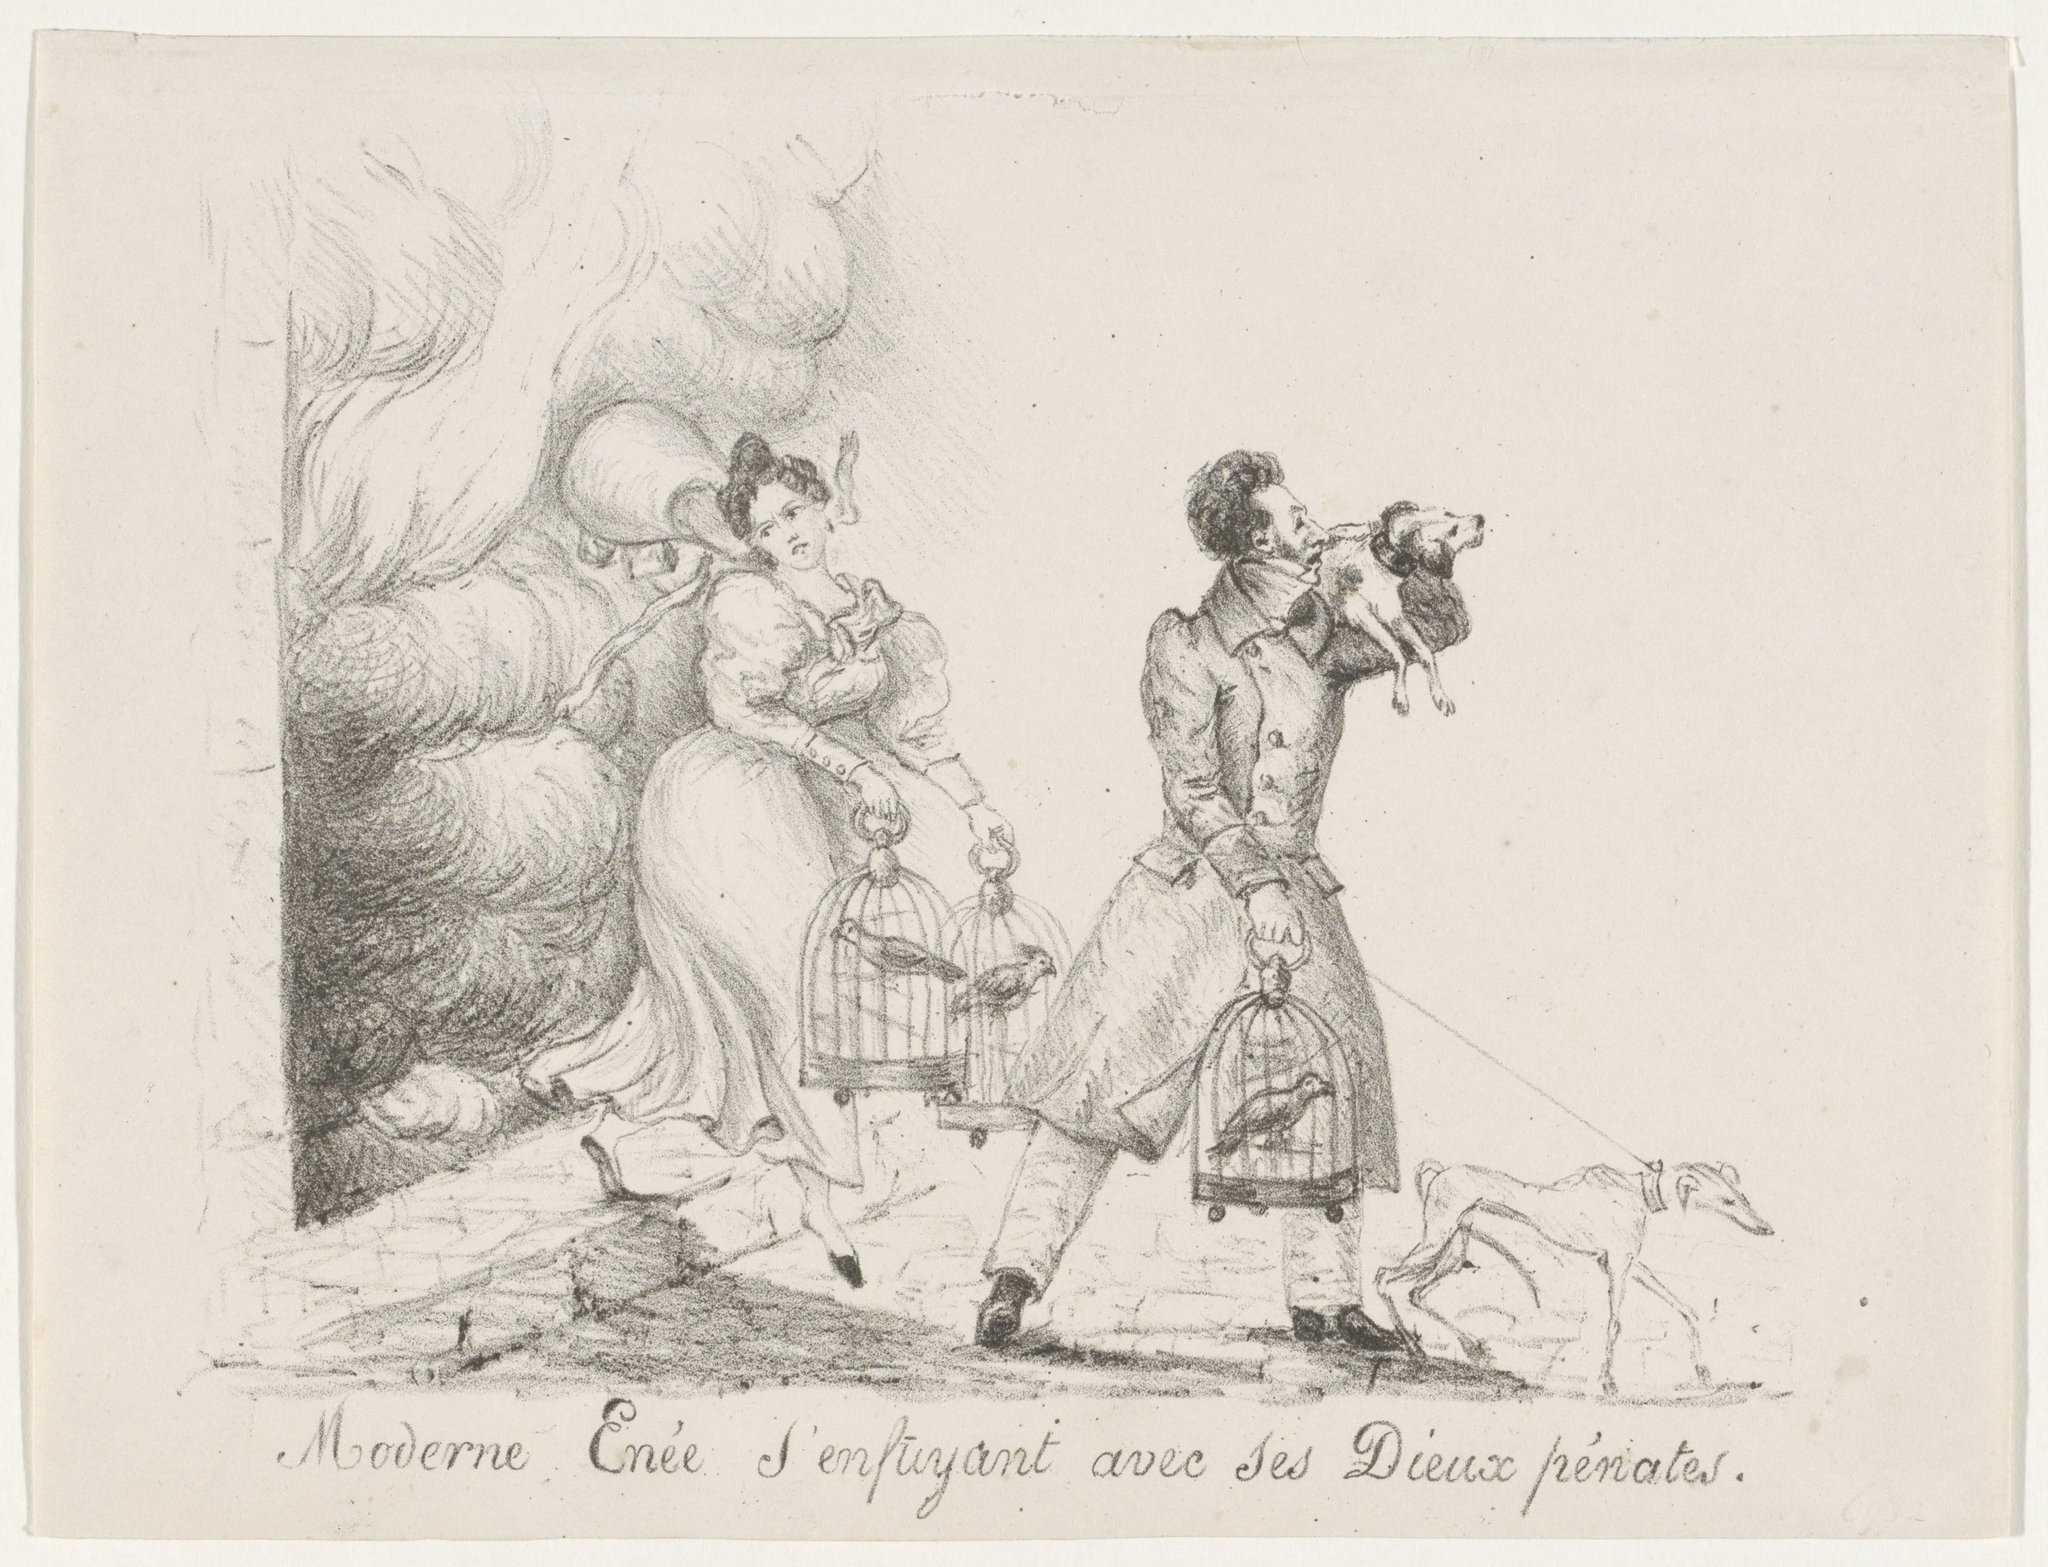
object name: print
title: Spotprent op de vlucht van Eugène, prins van Ligne, 1834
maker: Anonymous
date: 1834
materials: paper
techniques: lithograph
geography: belgium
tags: politician, on fire, ablaze, rescue from fire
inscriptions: collector's mark: Lugt 2228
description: Spotprent op Eugène François Charles Joseph Lamoral de Ligne, 8ste prins van Ligne, die samen met zijn vrouw Nathalie-Charlotte de Trazegnies hun brandende huis moeten ontvluchten, 1834. Eugène de Ligne was een Orangist en haalde zich de volkswoede van de Belgen op de hals waarbij zijn residentie in Brussel werd geplunderd en in brand gestoken. Hun vlucht en het redden van twee honden en drie vogels in kooien uit het huis wordt vegeleken met de vlucht van Aeneas met de Penaten uit Troje.